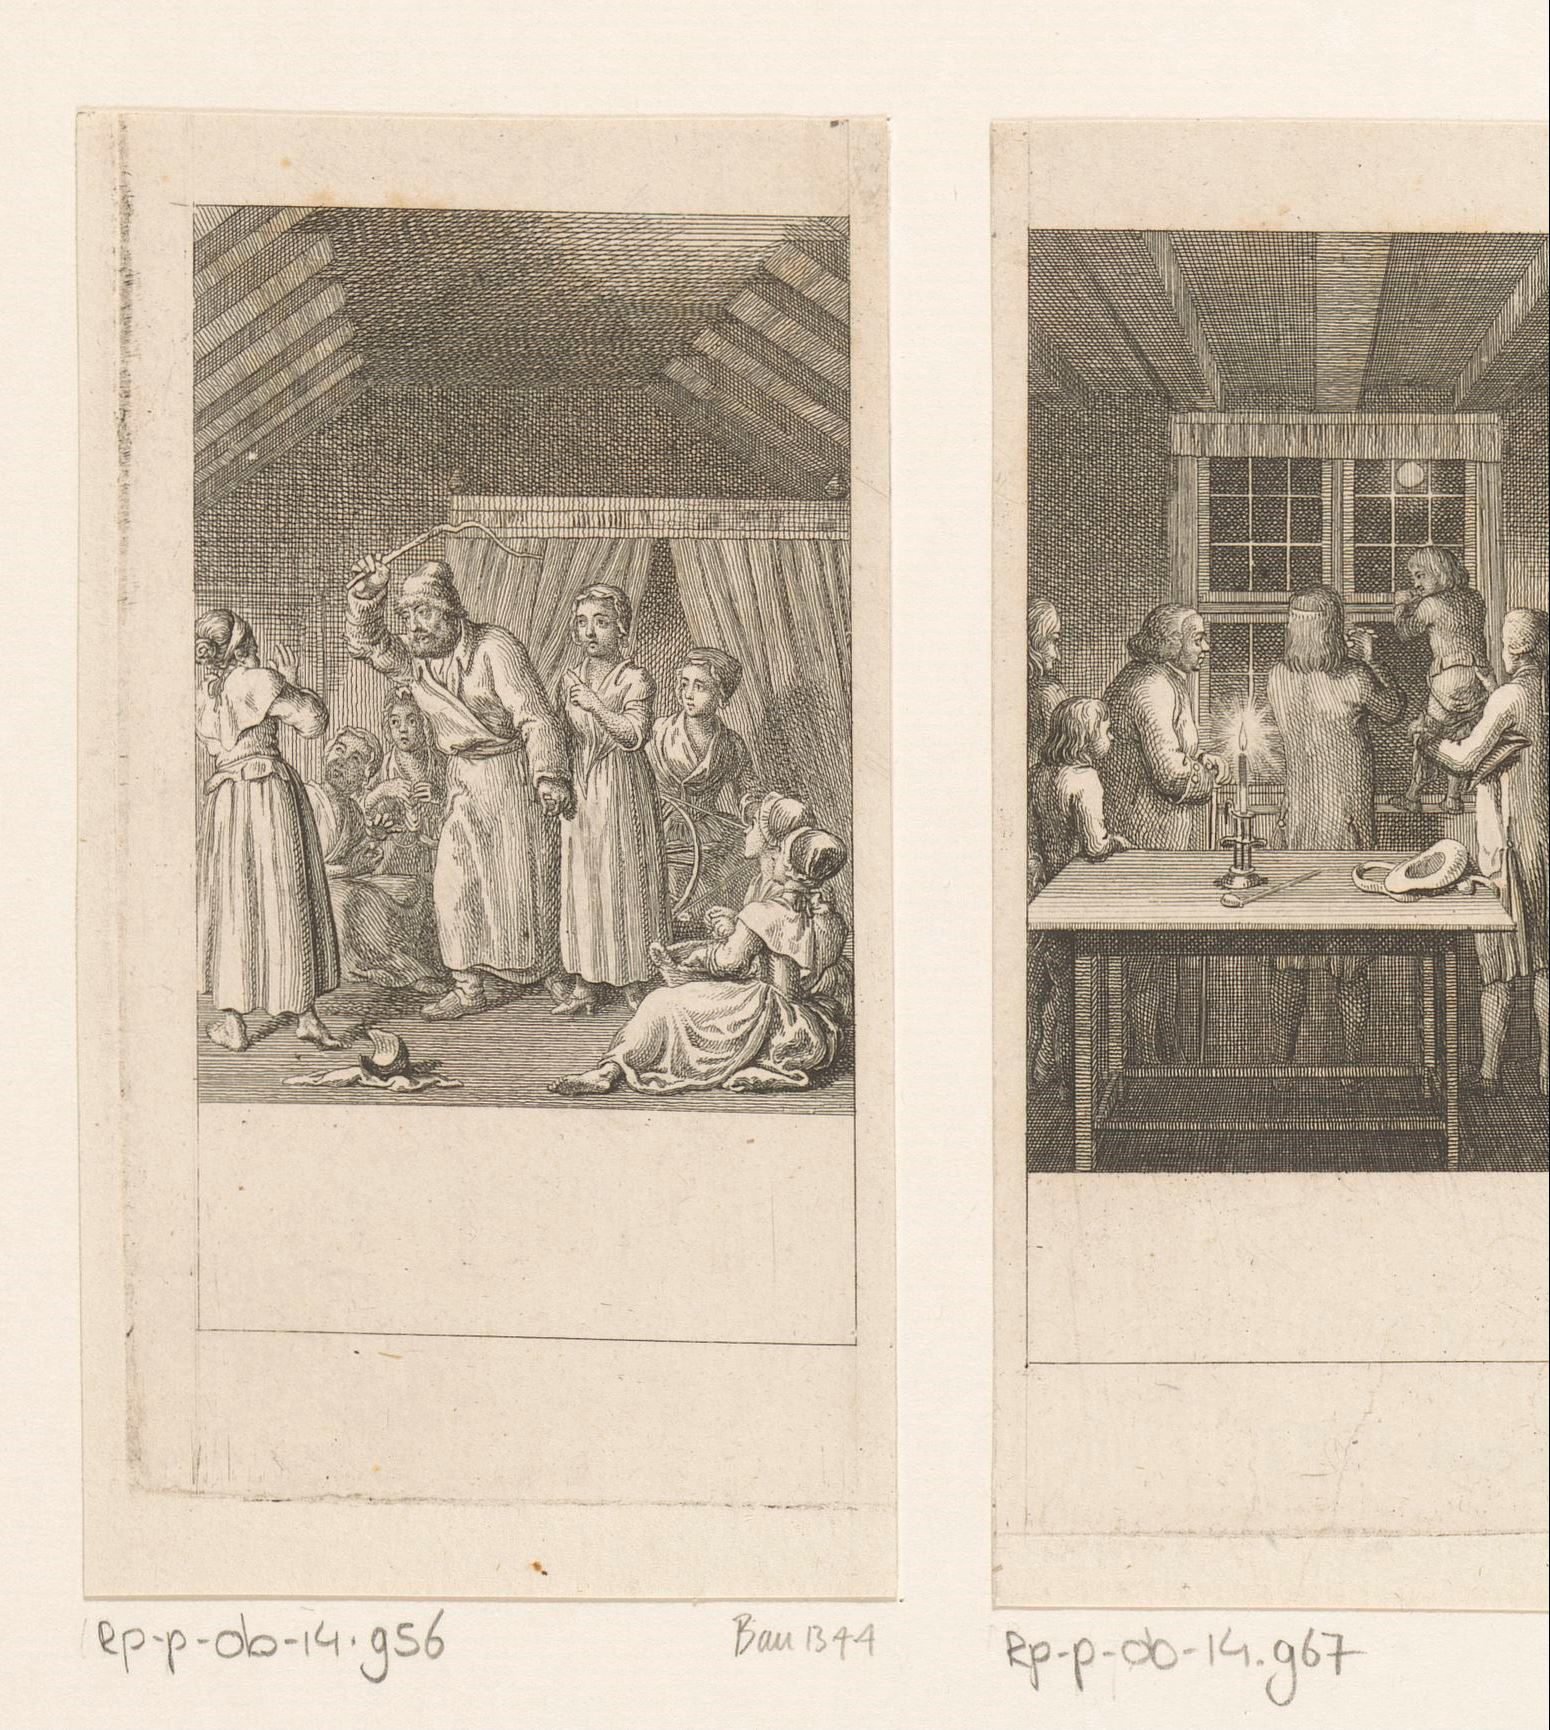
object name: print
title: Rosenfeld en zijn zeven vrouwen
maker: daniel nikolaus chodowiecki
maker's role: draughtsman, print maker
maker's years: 1726-1801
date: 1788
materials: paper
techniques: etching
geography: berlin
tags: master ~ enslaved person, whip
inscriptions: collector's mark: Lugt 2228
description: Vervaardigd voor een serie over Duitse rages. Latere staat gebruikt voor: Berliner genealogischen Calender auf das Jahr 1789. [Berlijn]: s.n., [1788].